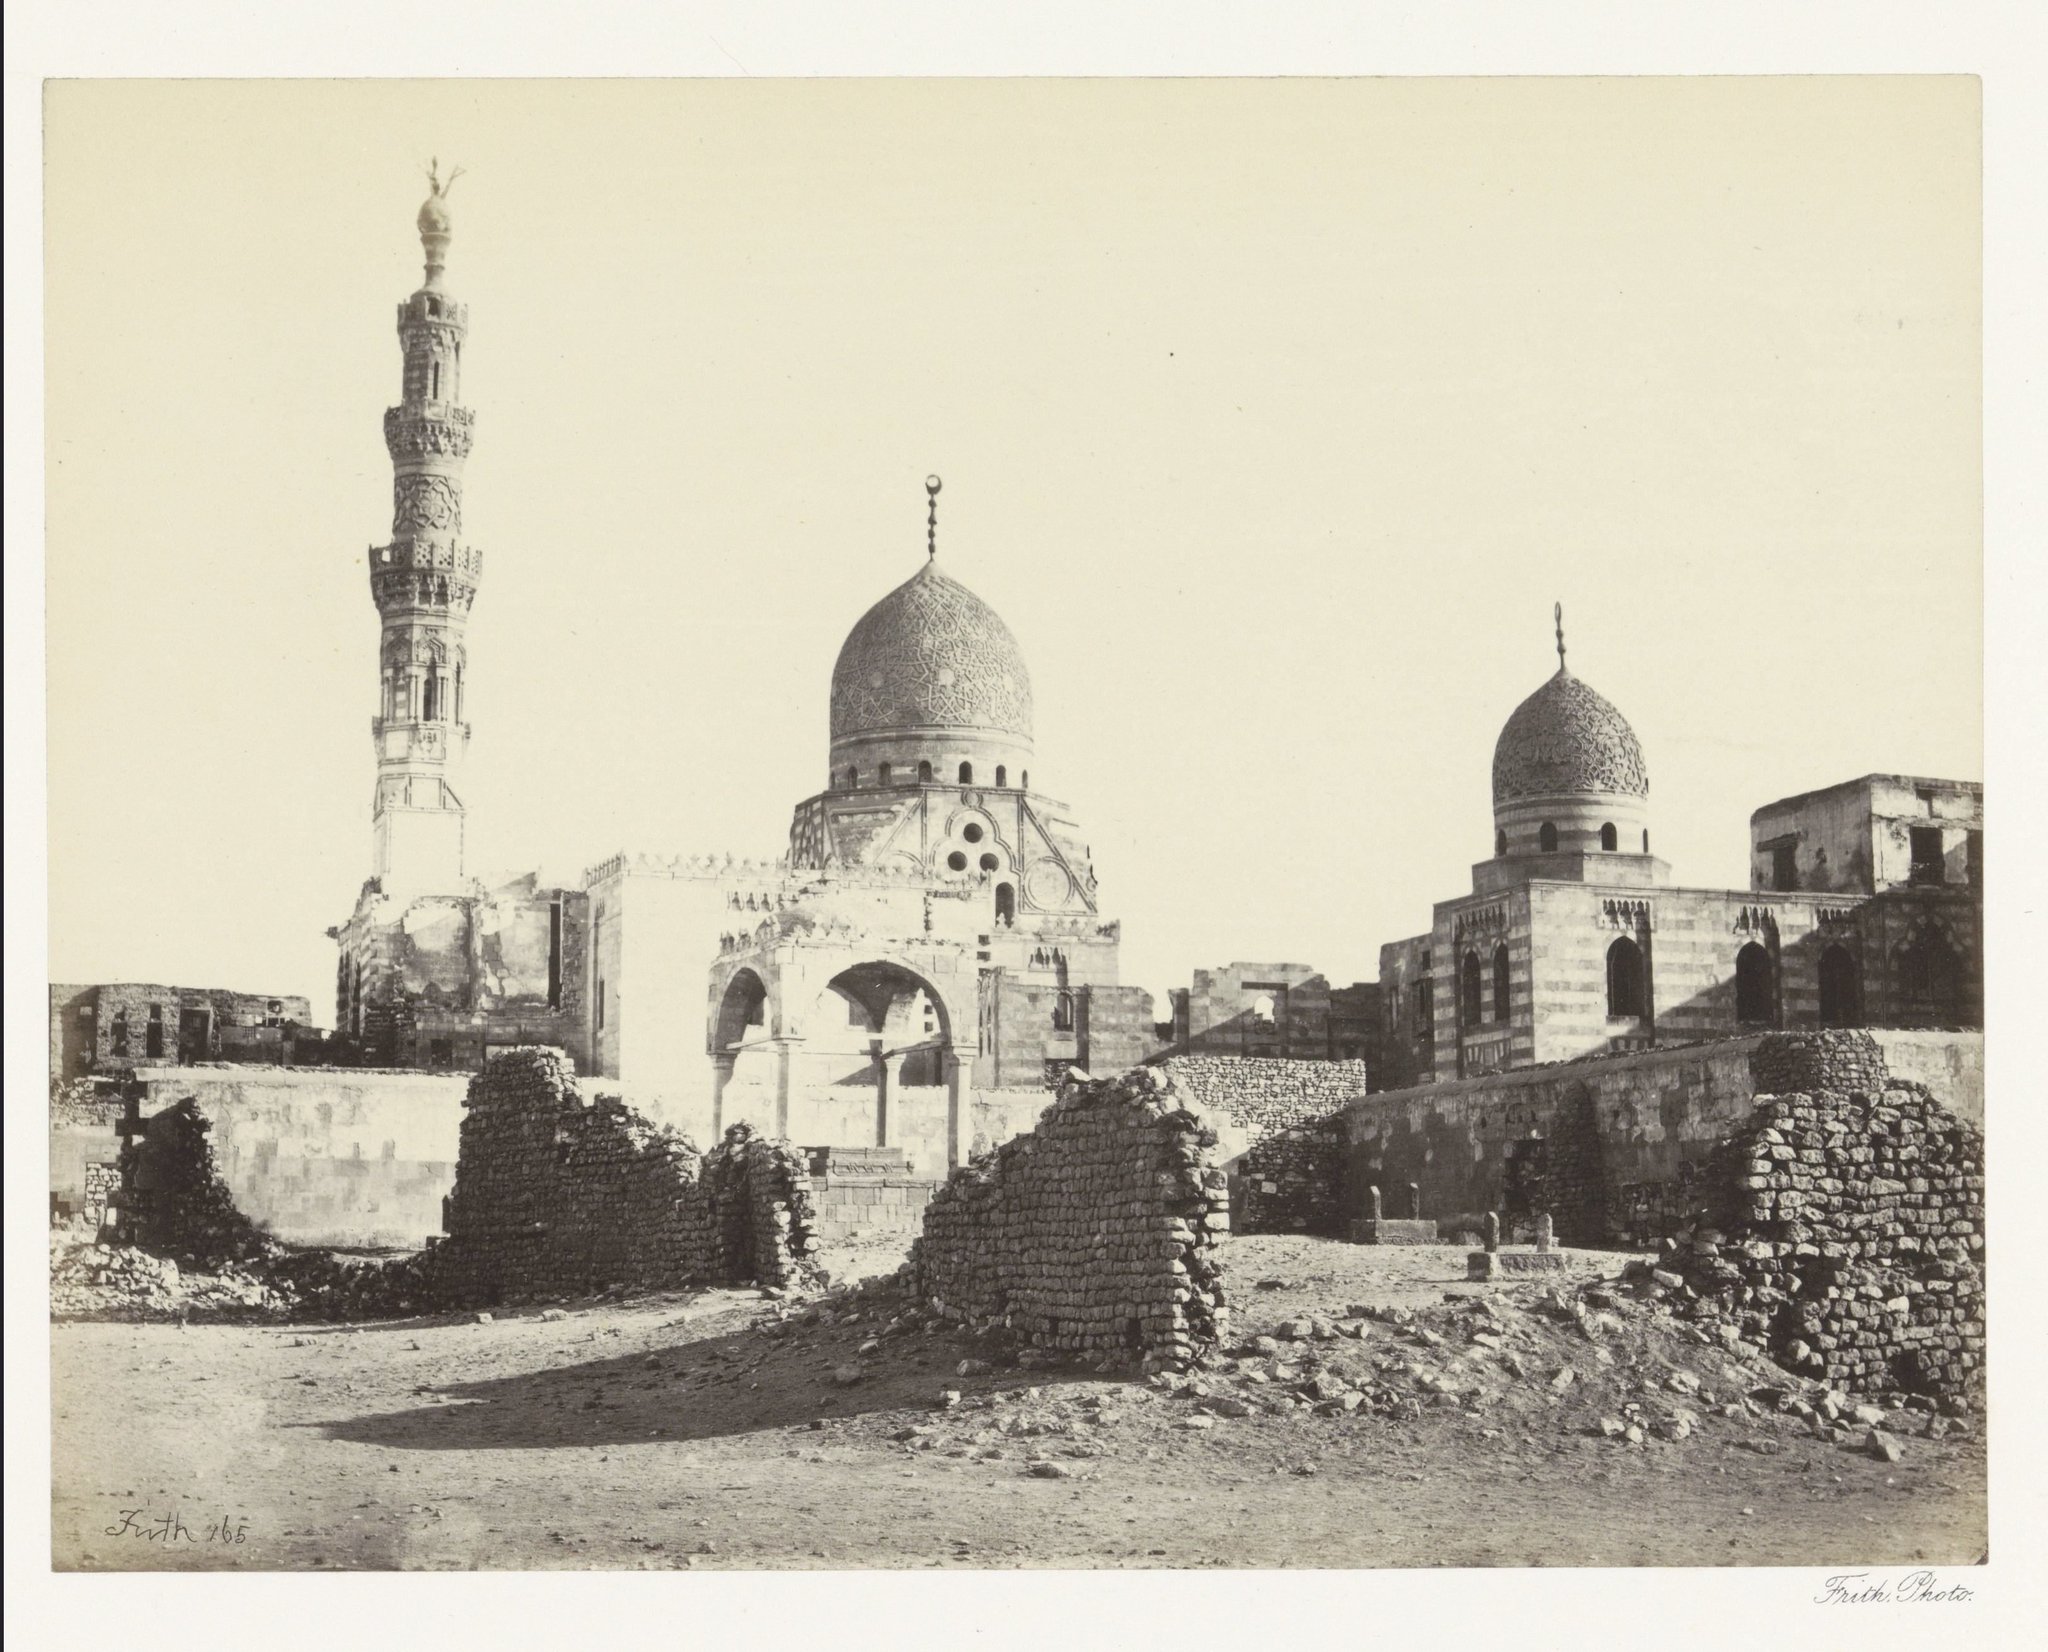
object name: page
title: The mosque of Kaitbey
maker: francis frith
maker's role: publisher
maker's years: 1822-1898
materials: paper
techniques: albumen print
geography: cairo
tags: temple, shrine ~ islam, mohammedanism